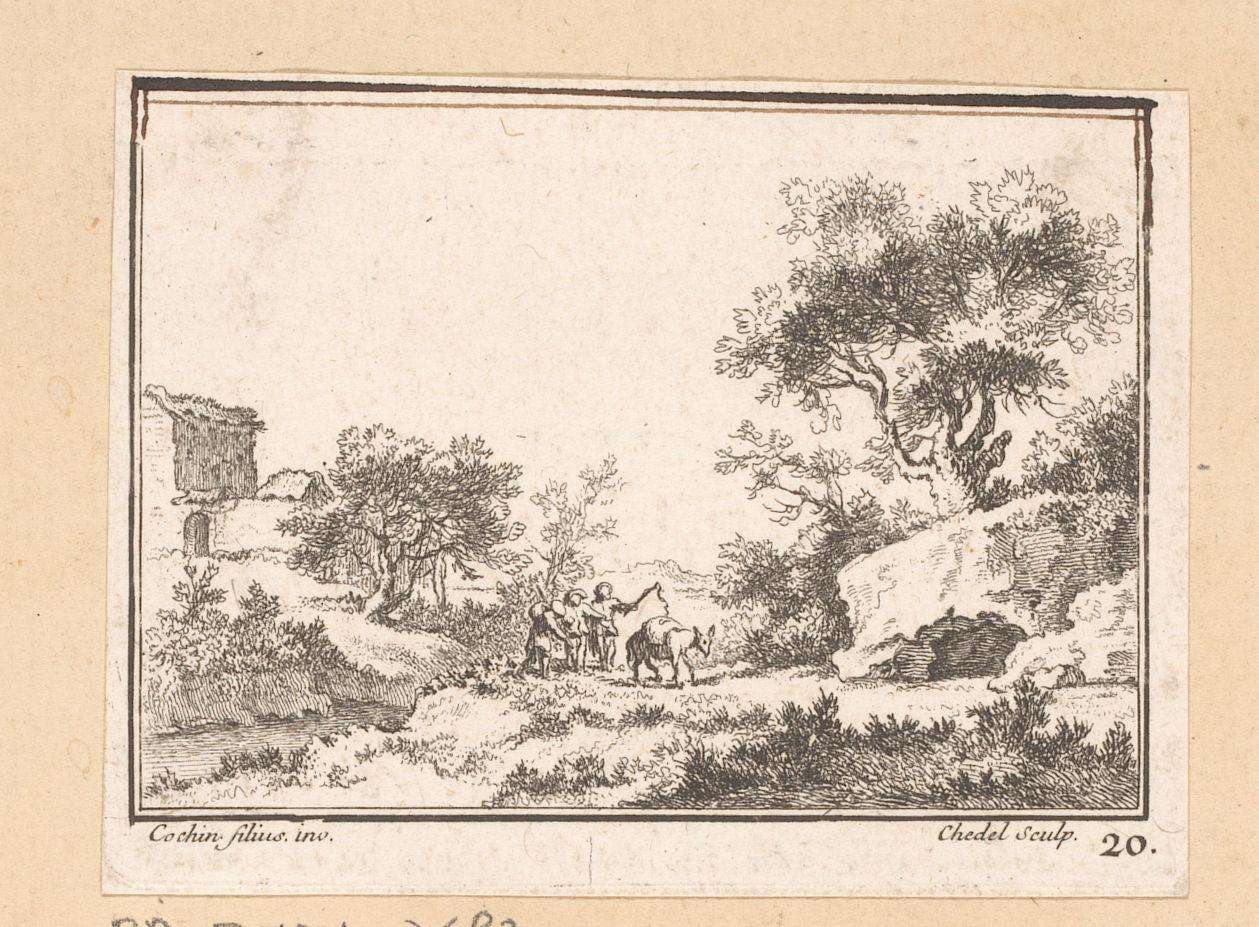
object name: print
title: Landschap met drie figuren met een ezel op een pad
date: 1725-1763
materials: ink, paper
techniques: etching, pen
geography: france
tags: ass, donkey, road, path, landscapes (+ landscape with figures, staffage)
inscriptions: collector's mark: Lugt 2228